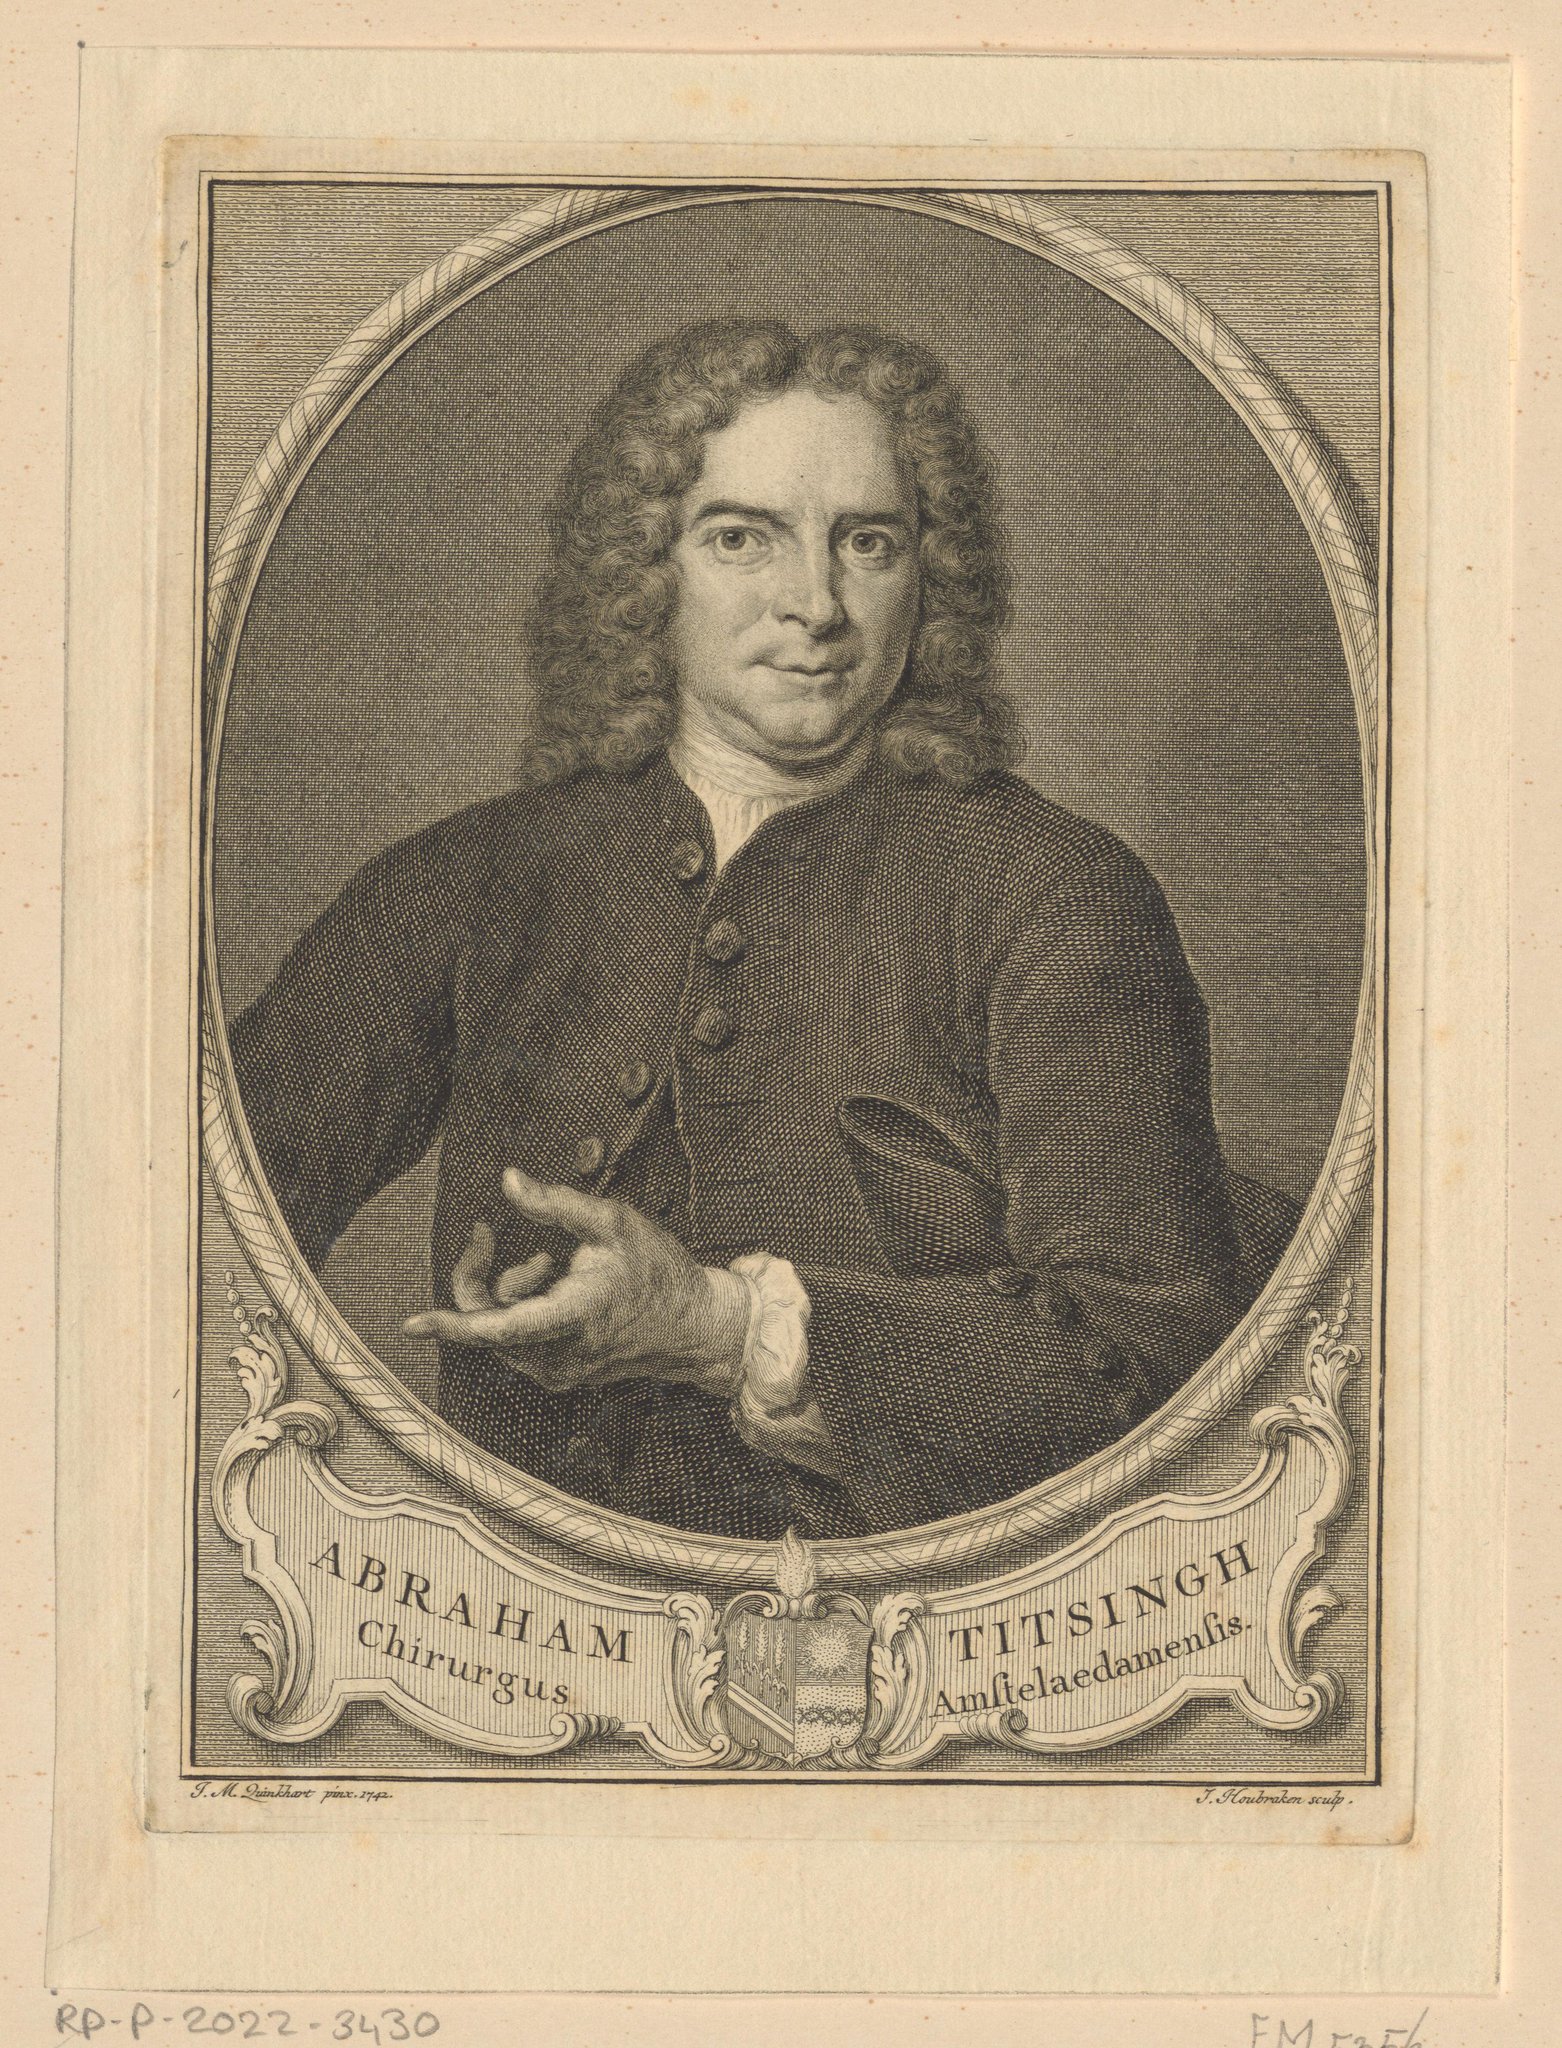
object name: print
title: Portret van Abraham Titsingh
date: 1742-1780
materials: paper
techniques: engraving, etching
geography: amsterdam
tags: historical persons, physician, doctor